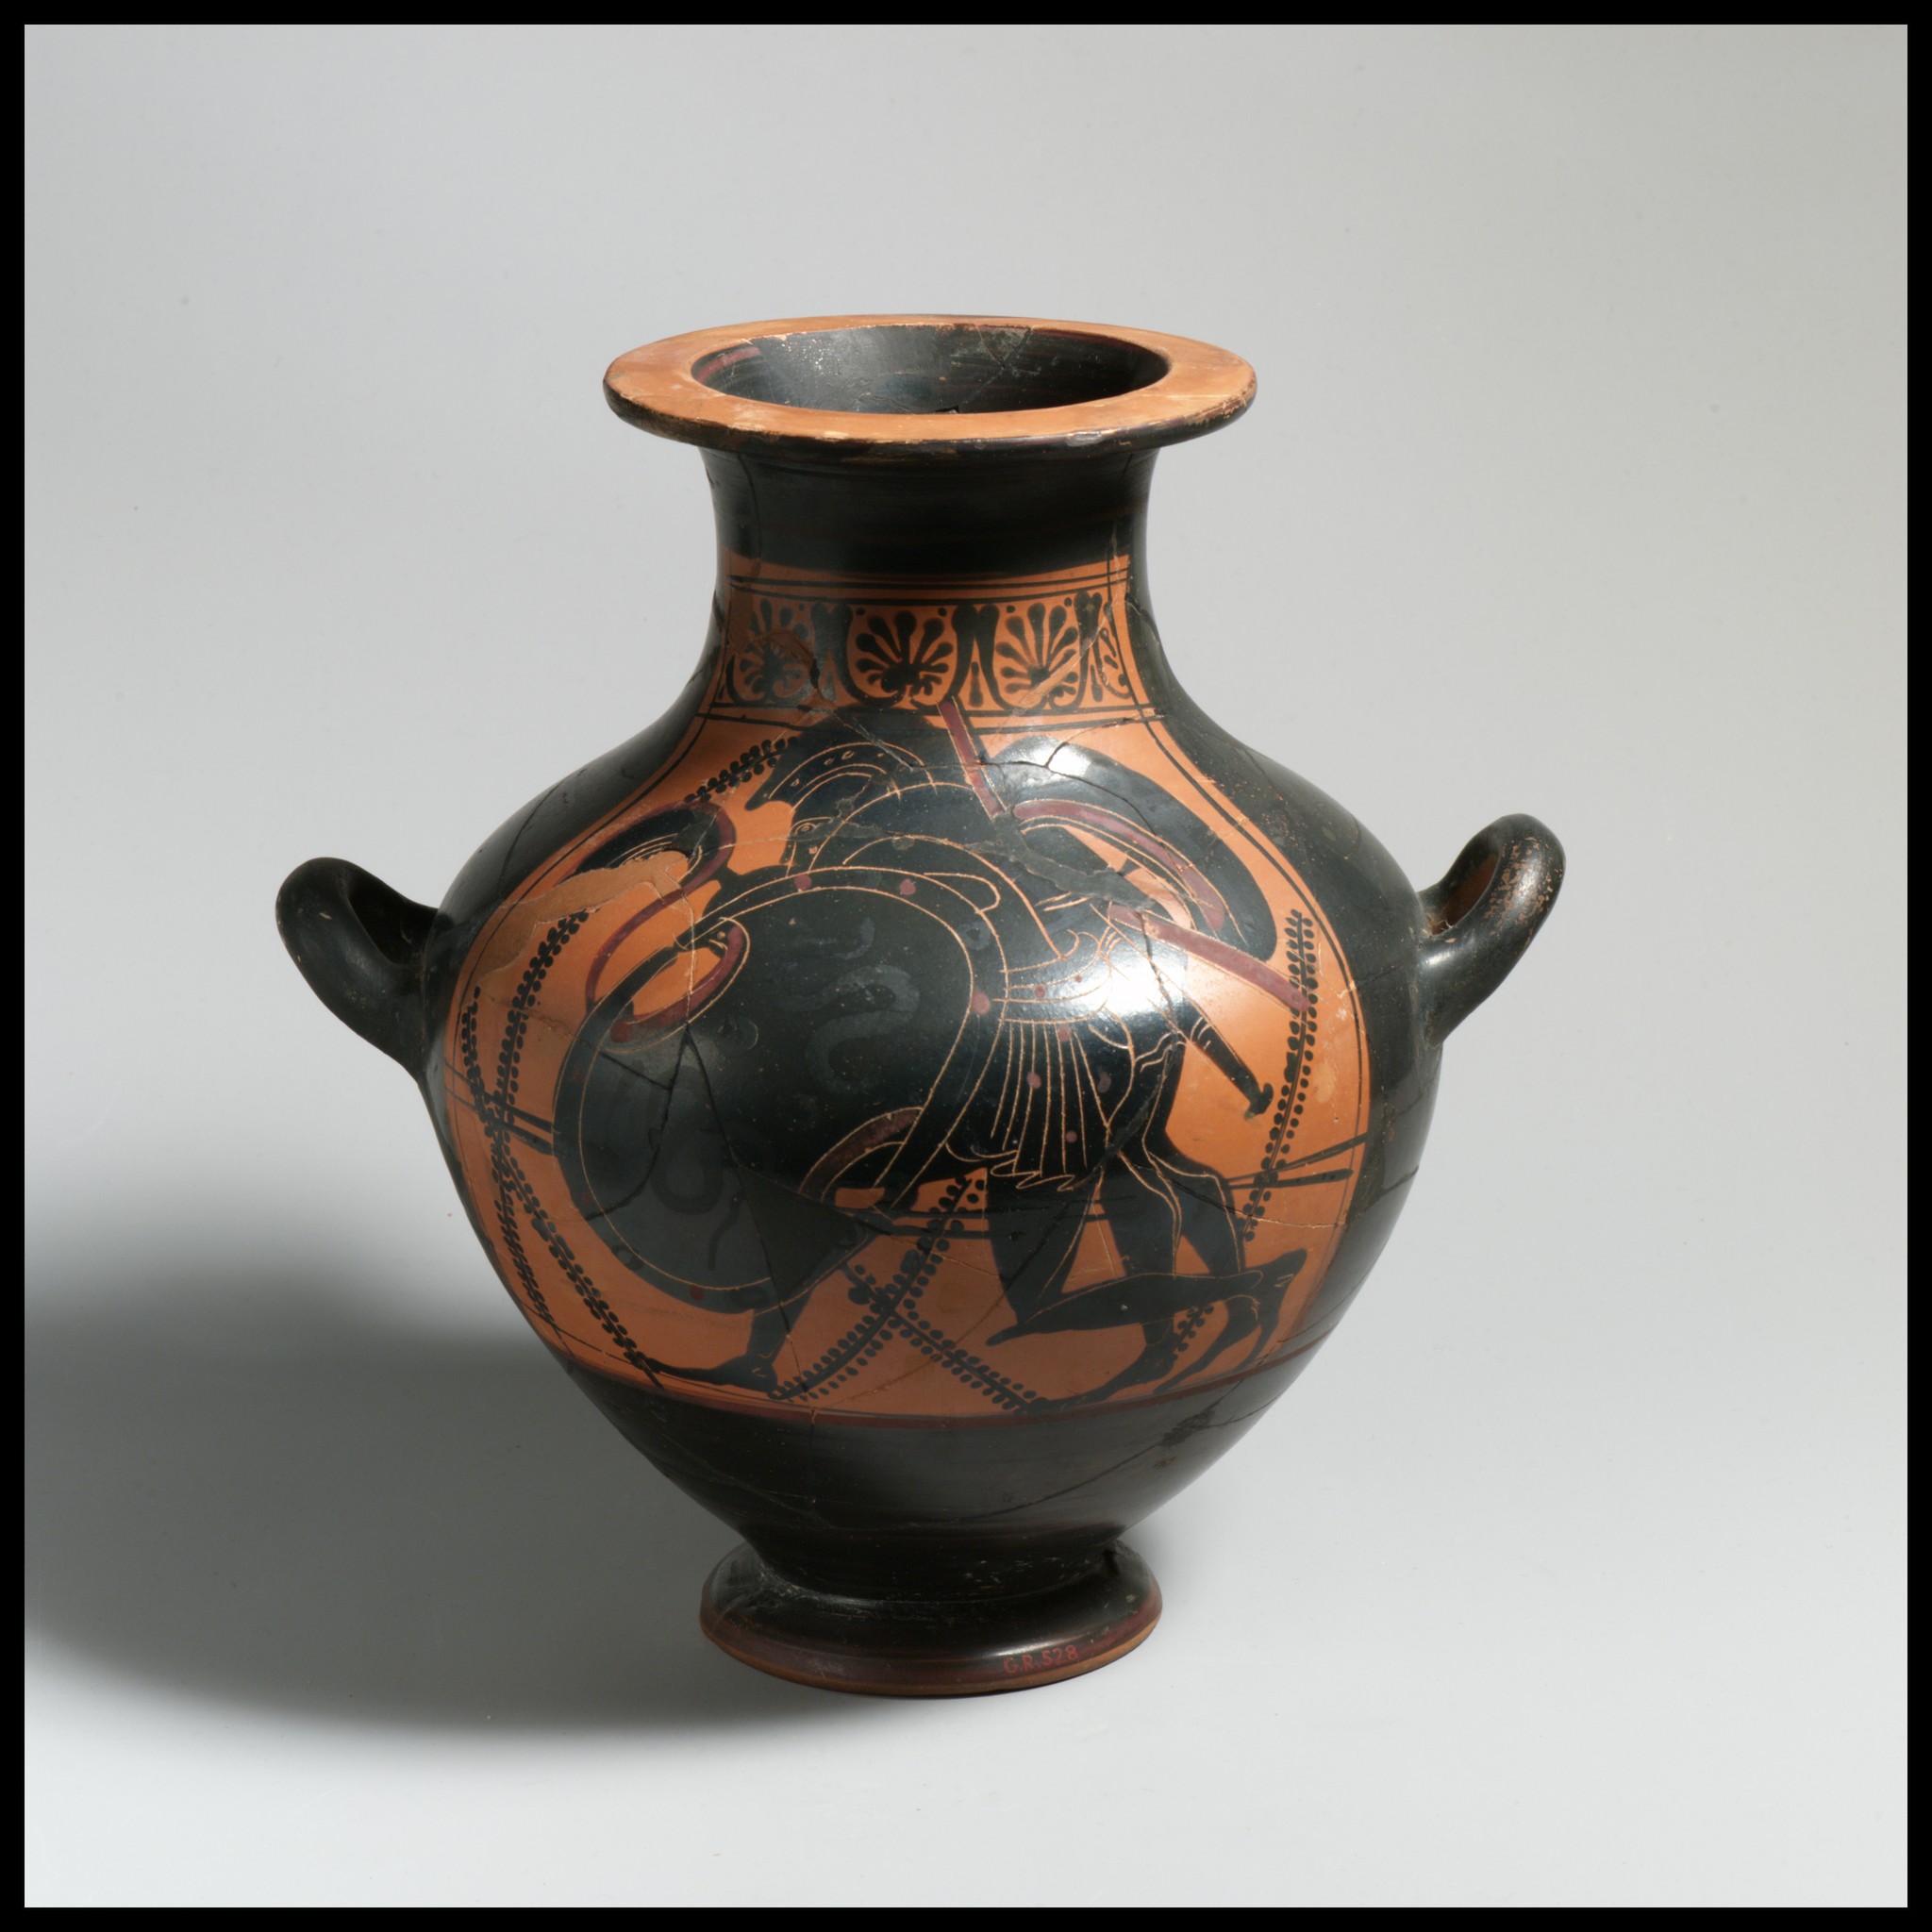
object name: hydria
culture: greek, attic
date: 490 BCE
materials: terracotta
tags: soldiers,shields